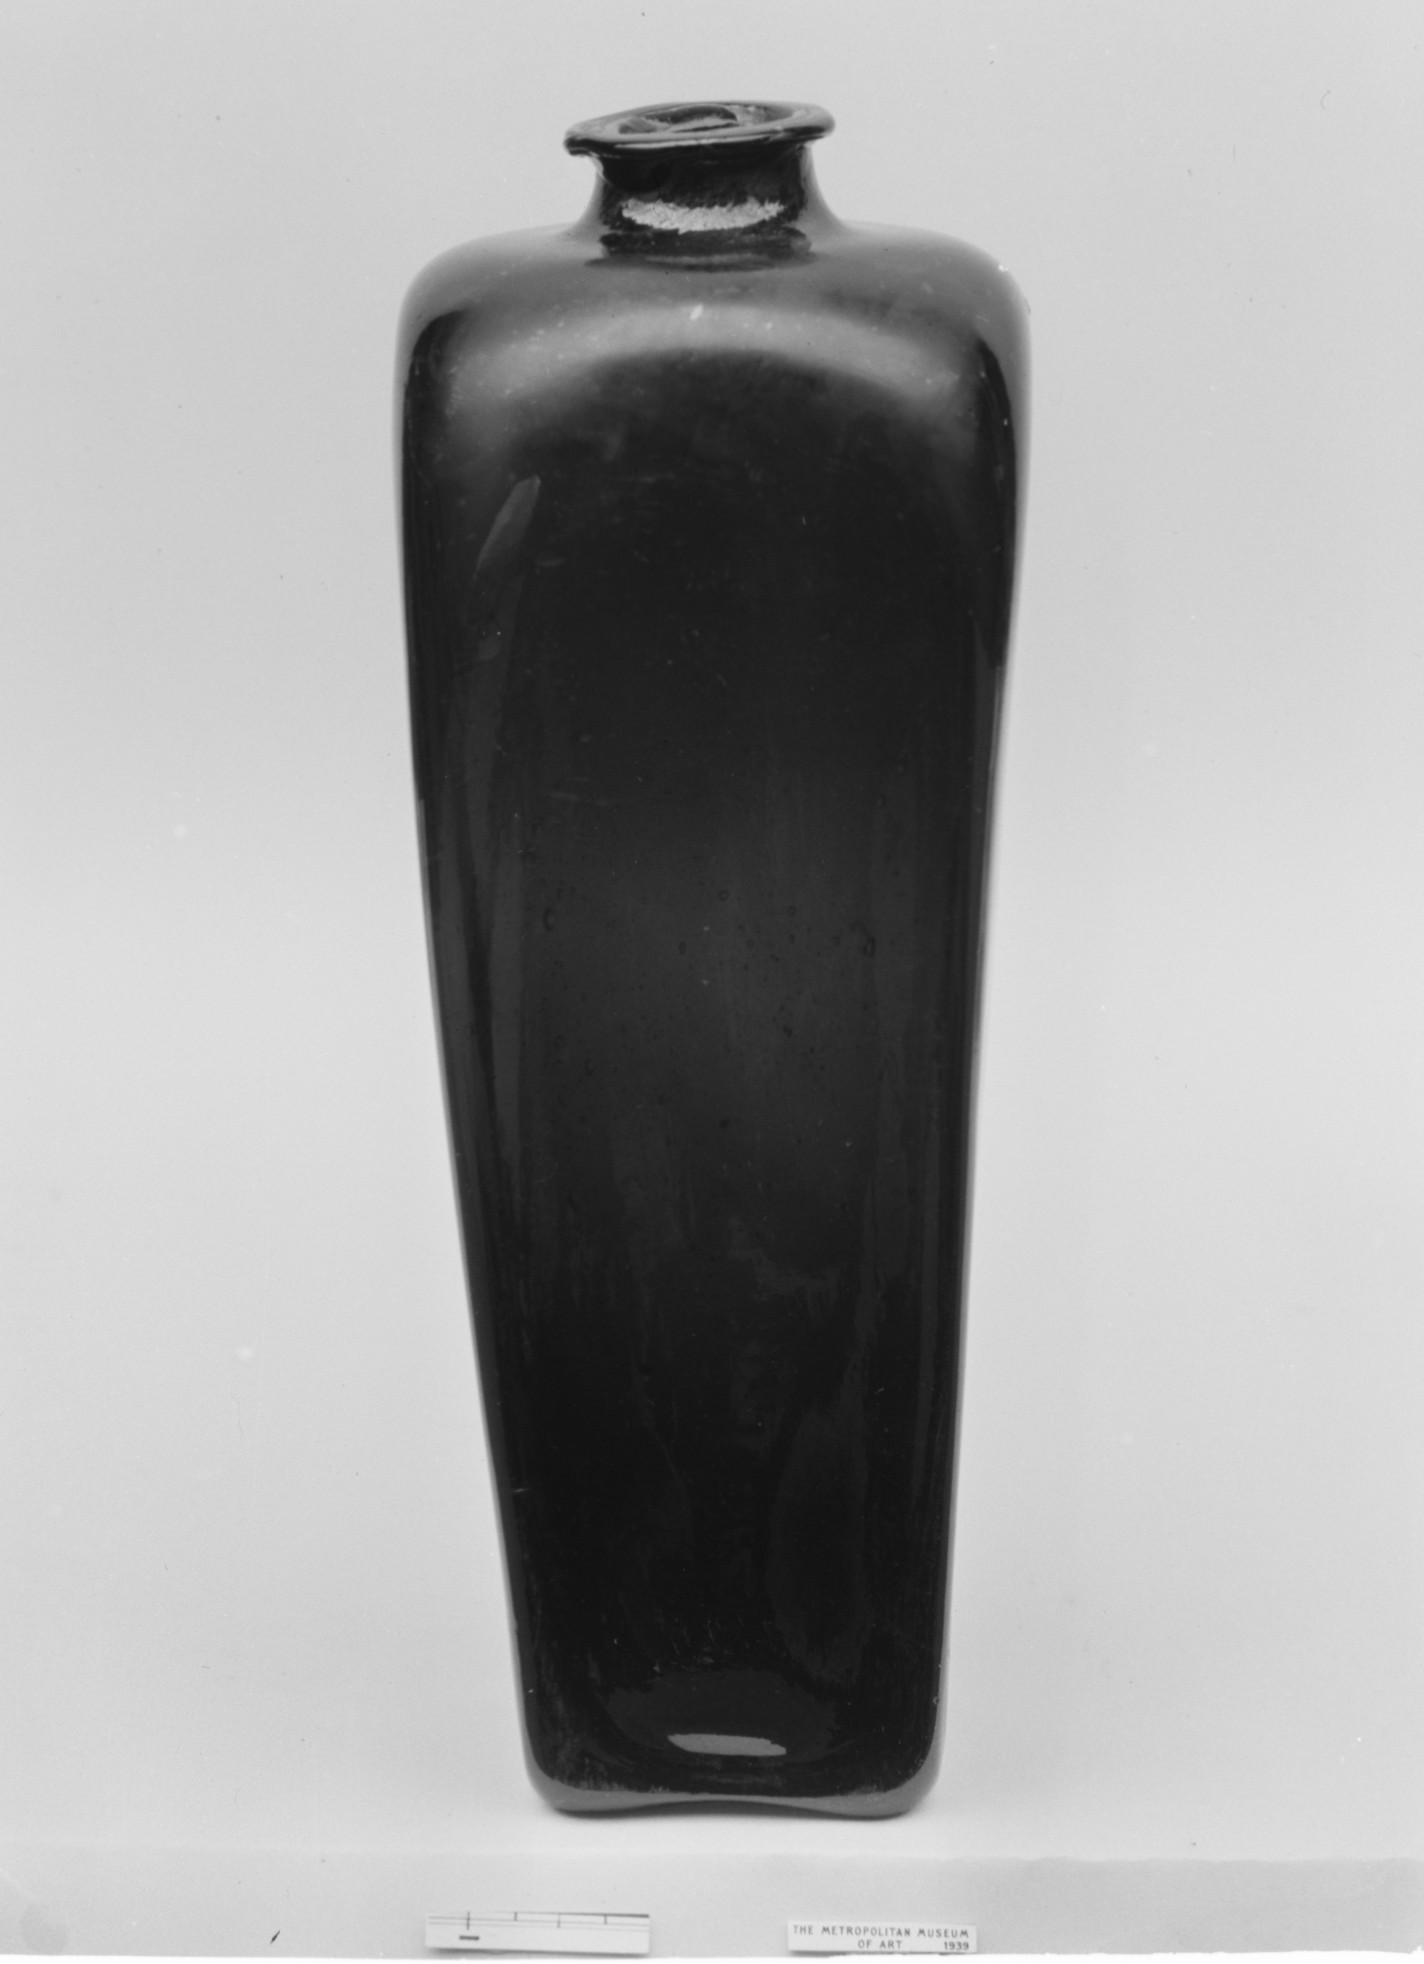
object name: bottle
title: Bottle (gineva)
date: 1701-1900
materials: glass